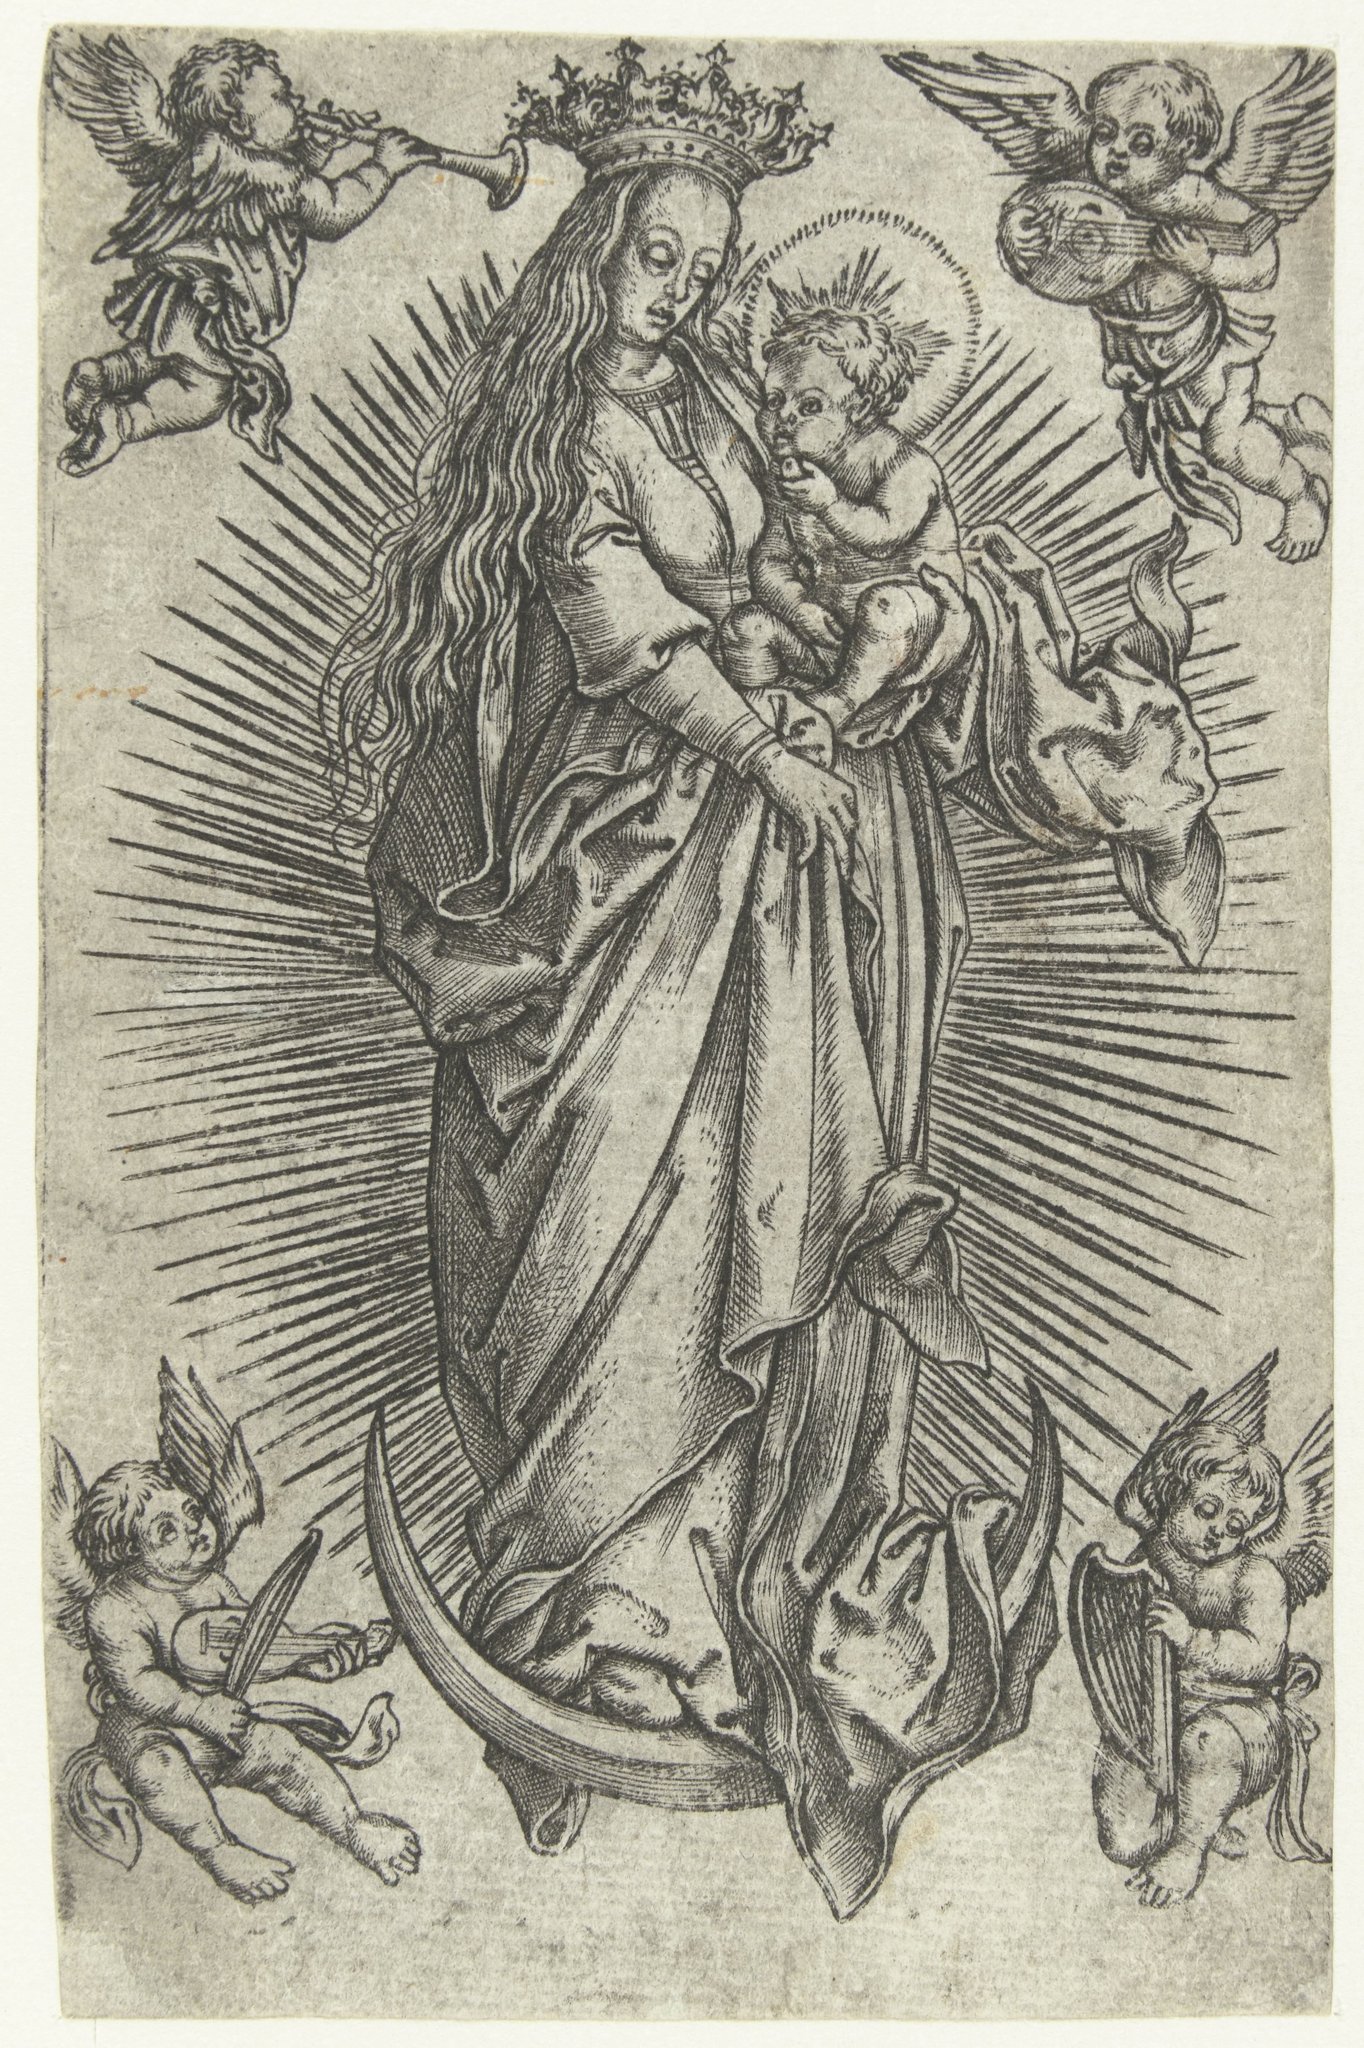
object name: print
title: Madonna op de maansikkel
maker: Anonymous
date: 1500-1525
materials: paper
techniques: engraving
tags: 'immaculata', 'purisima': mary, usually standing on a crescent moon, descending from heaven, exempt from original sin (sometimes trampling serpent)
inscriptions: collector's mark: Lugt 2228a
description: Maria gekroond, met Christuskind op maansikkel, omringd door stralenkrans. Kopie in spiegelbeeld waarbij vier musicerende engelen zijn toegevoegd.